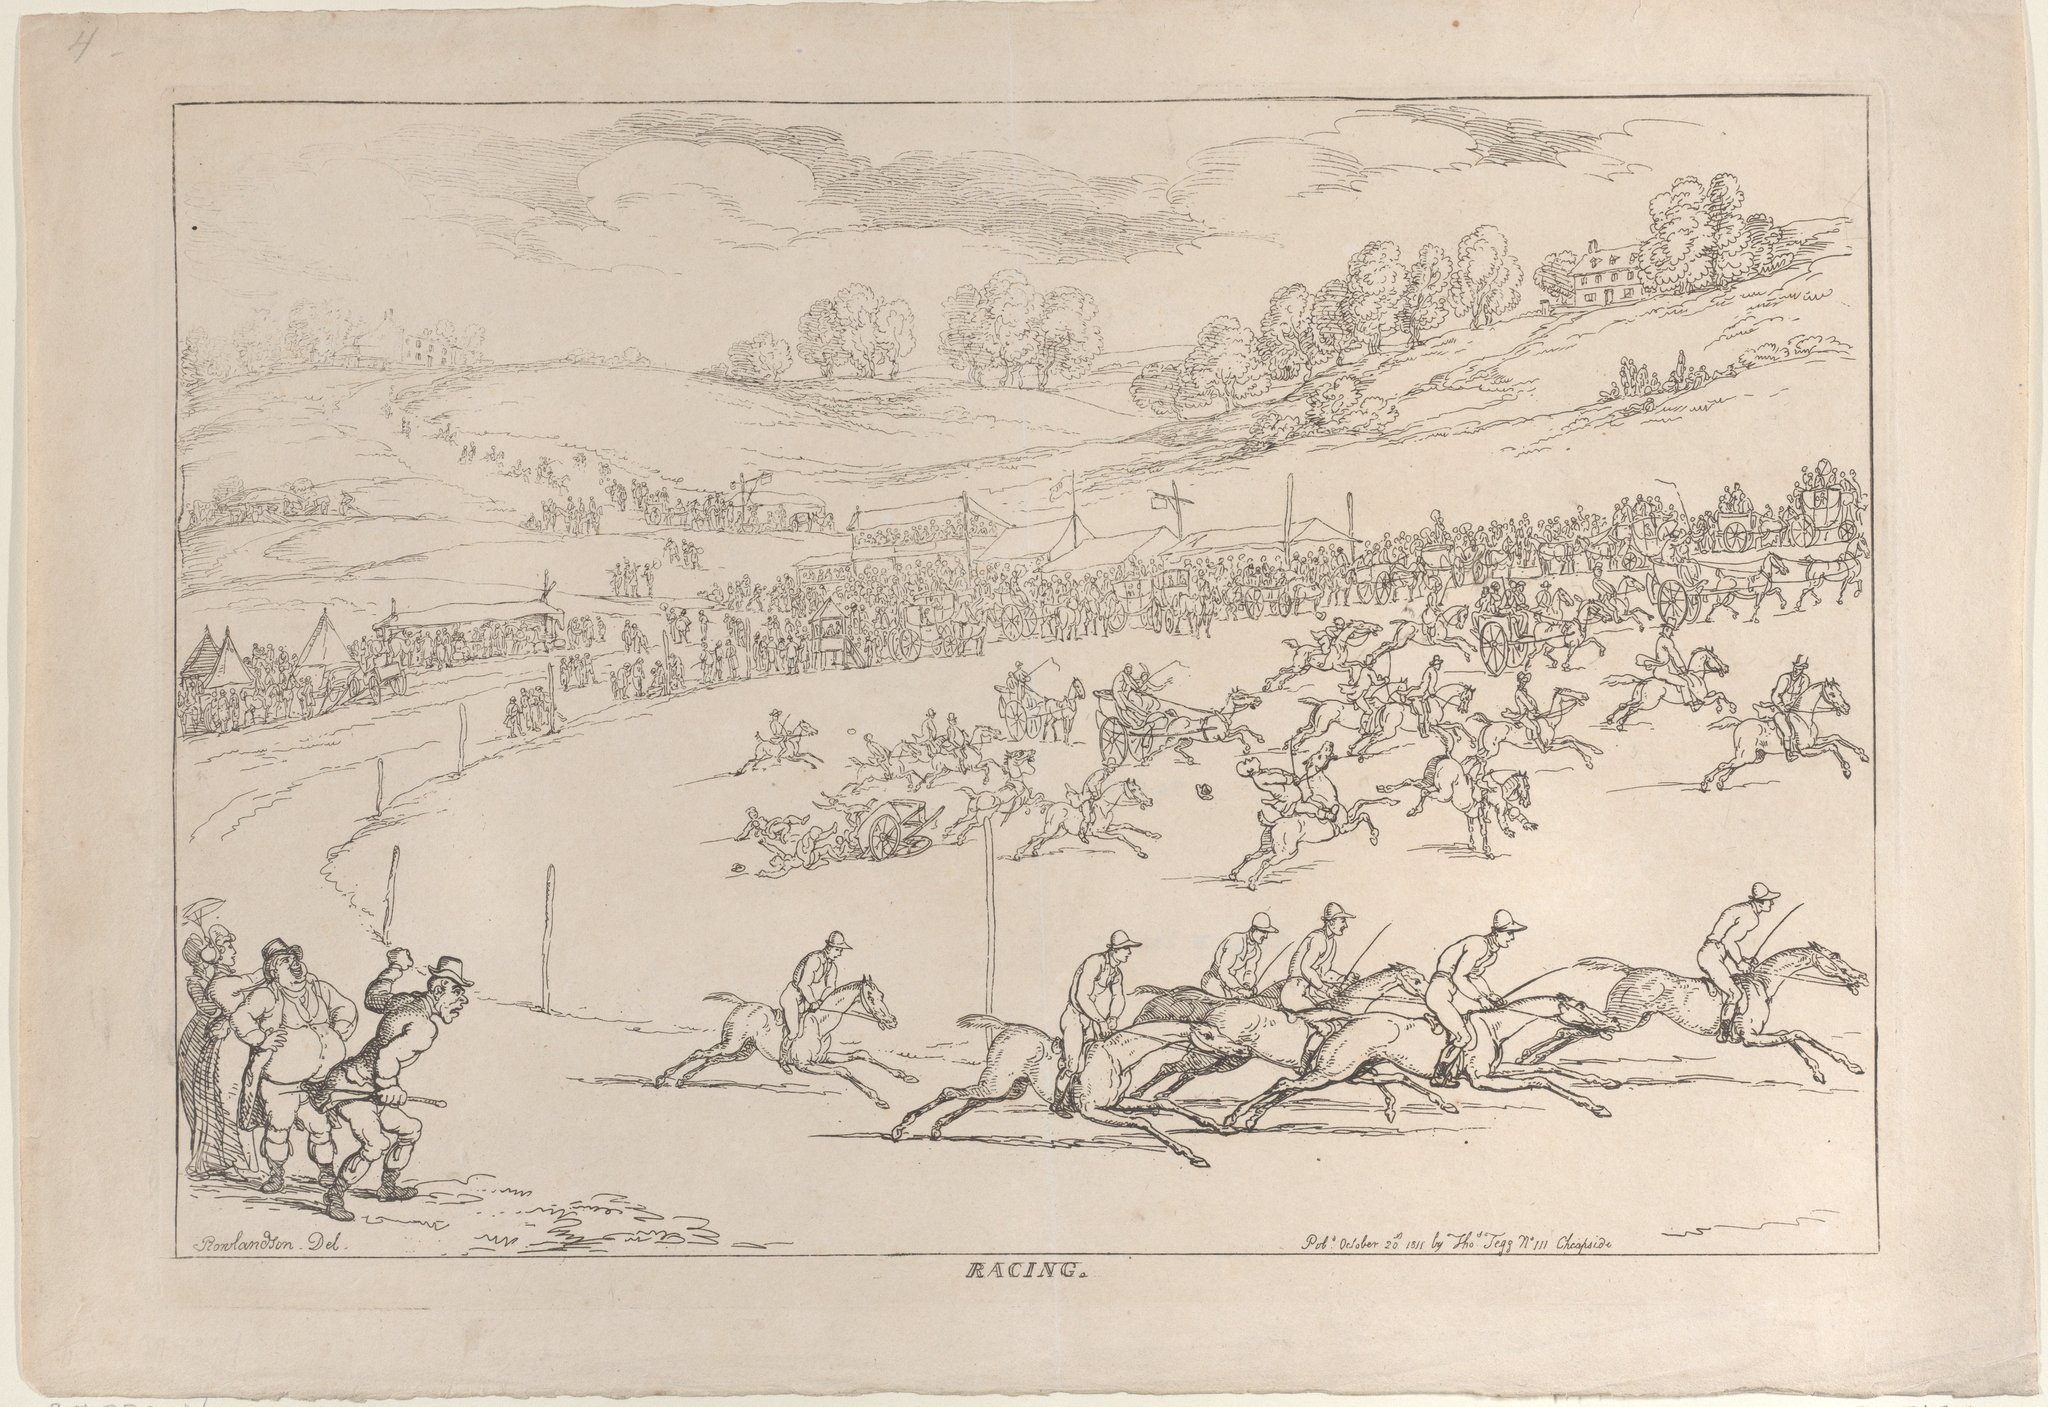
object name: print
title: Racing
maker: thomas rowlandson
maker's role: artist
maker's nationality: british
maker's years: 1757-1827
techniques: etching